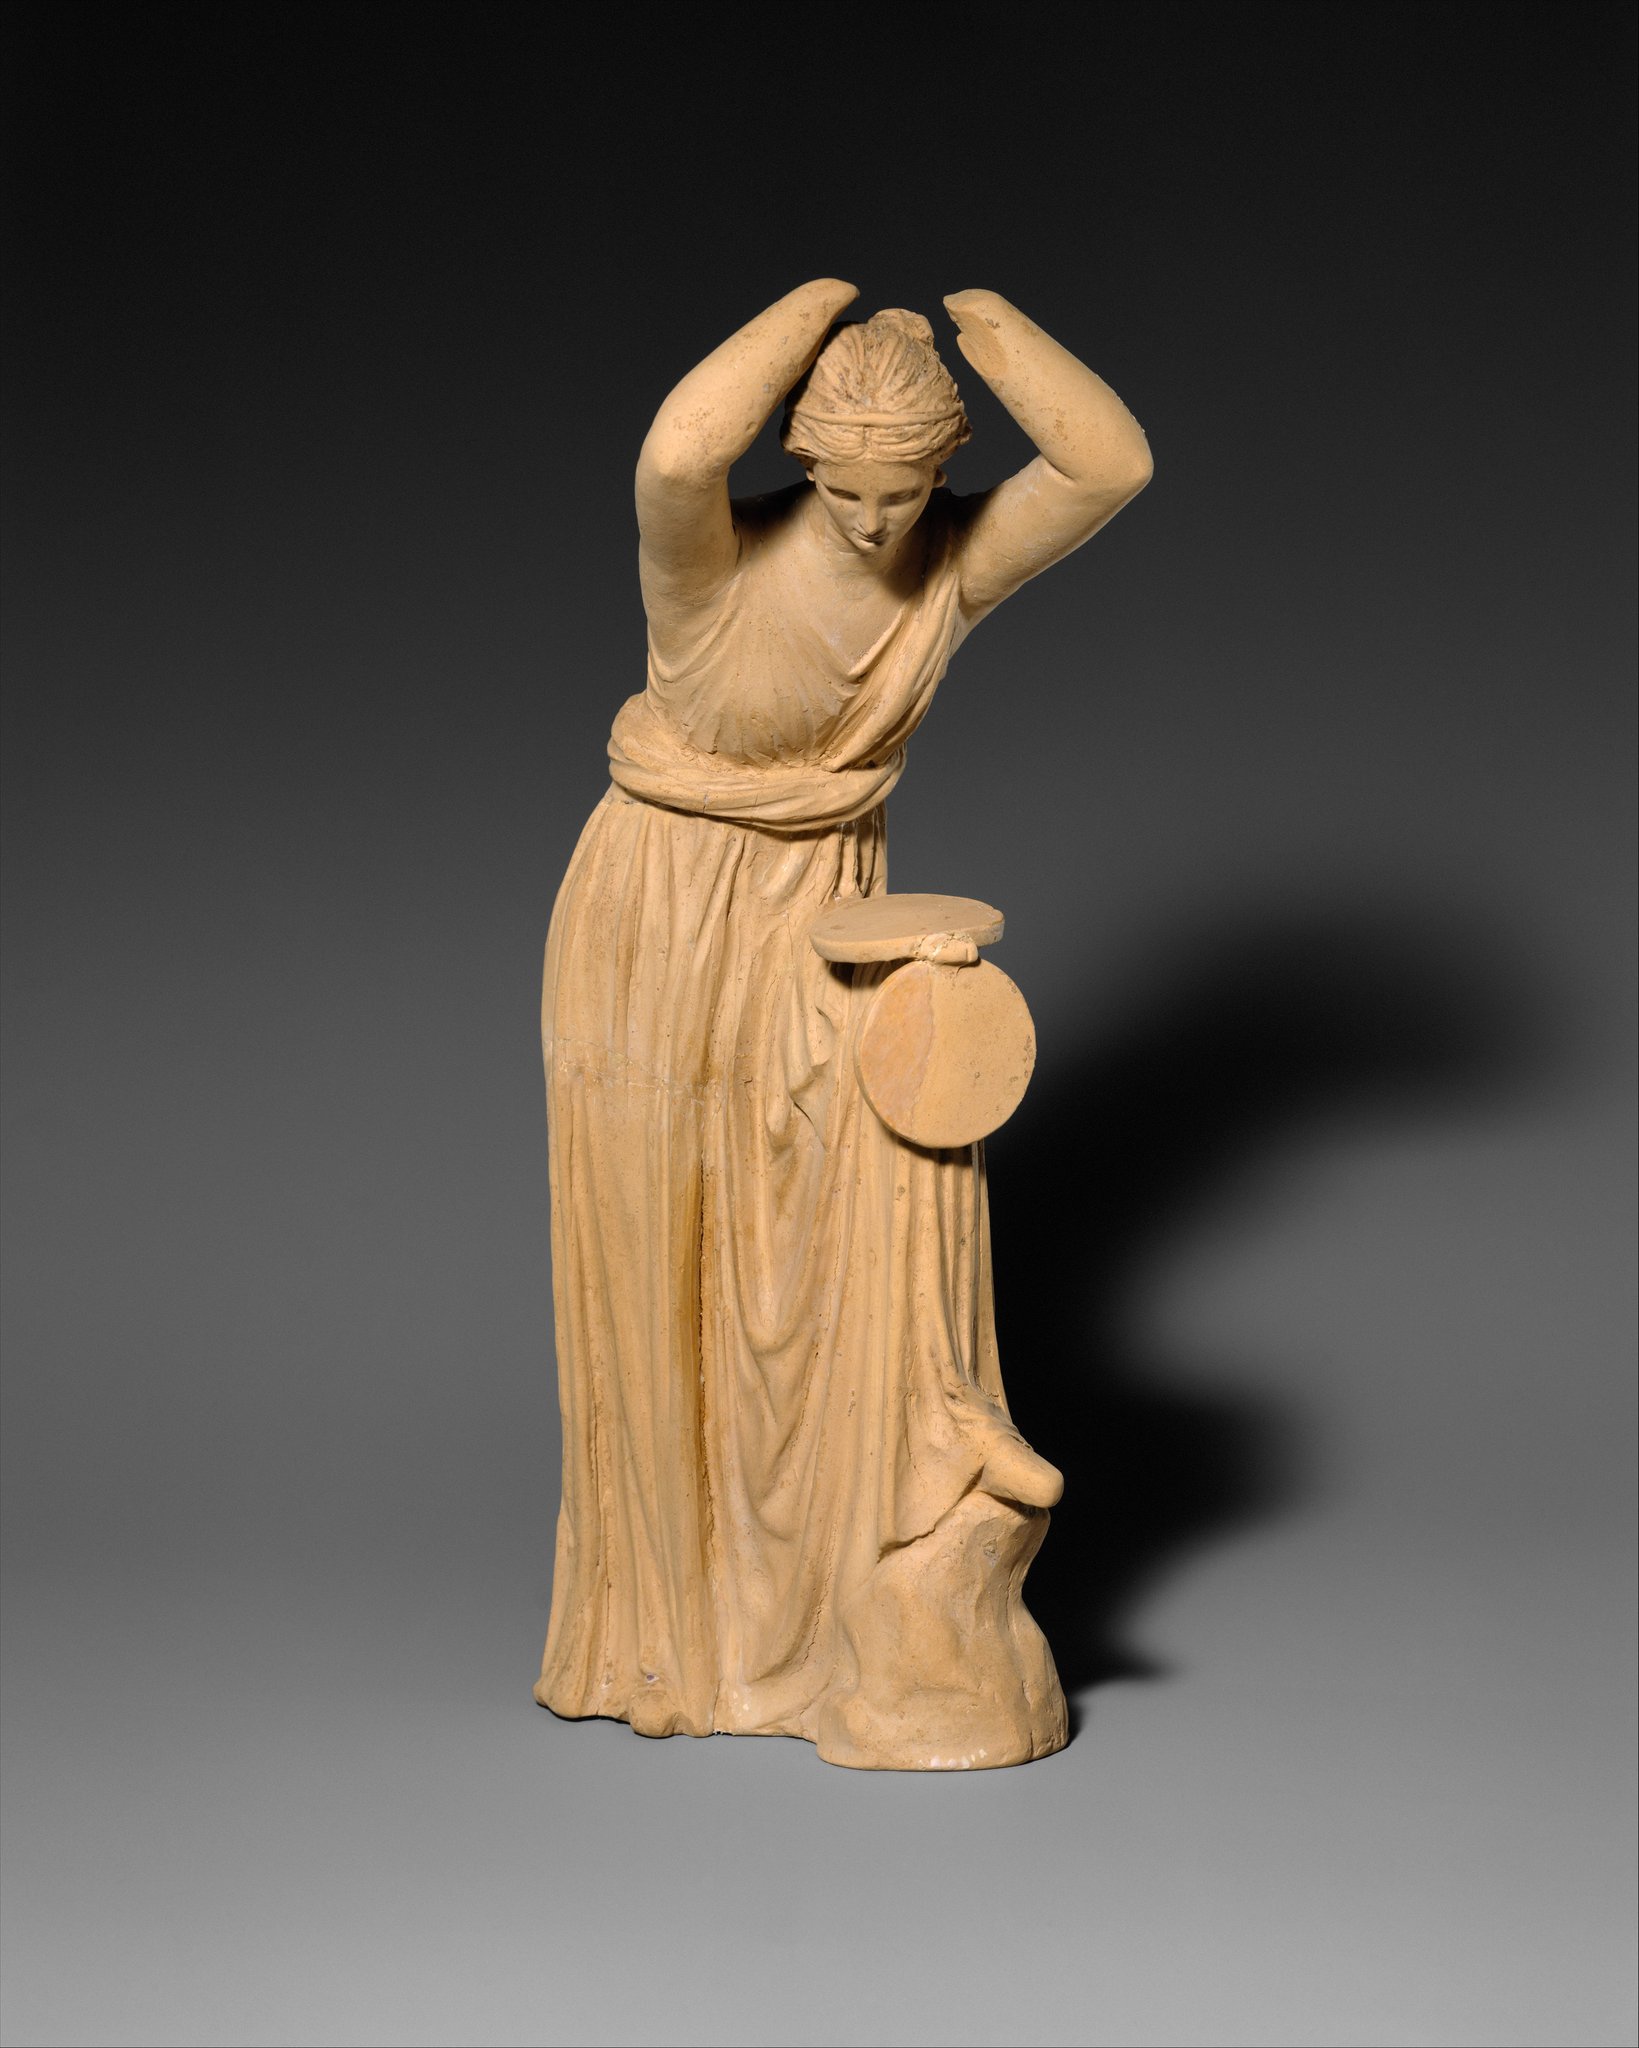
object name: statuette of a woman with foot on rock, mirror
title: Terracotta statuette of a woman looking into a box mirror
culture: greek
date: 300-101 BCE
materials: terracotta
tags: women,mirrors